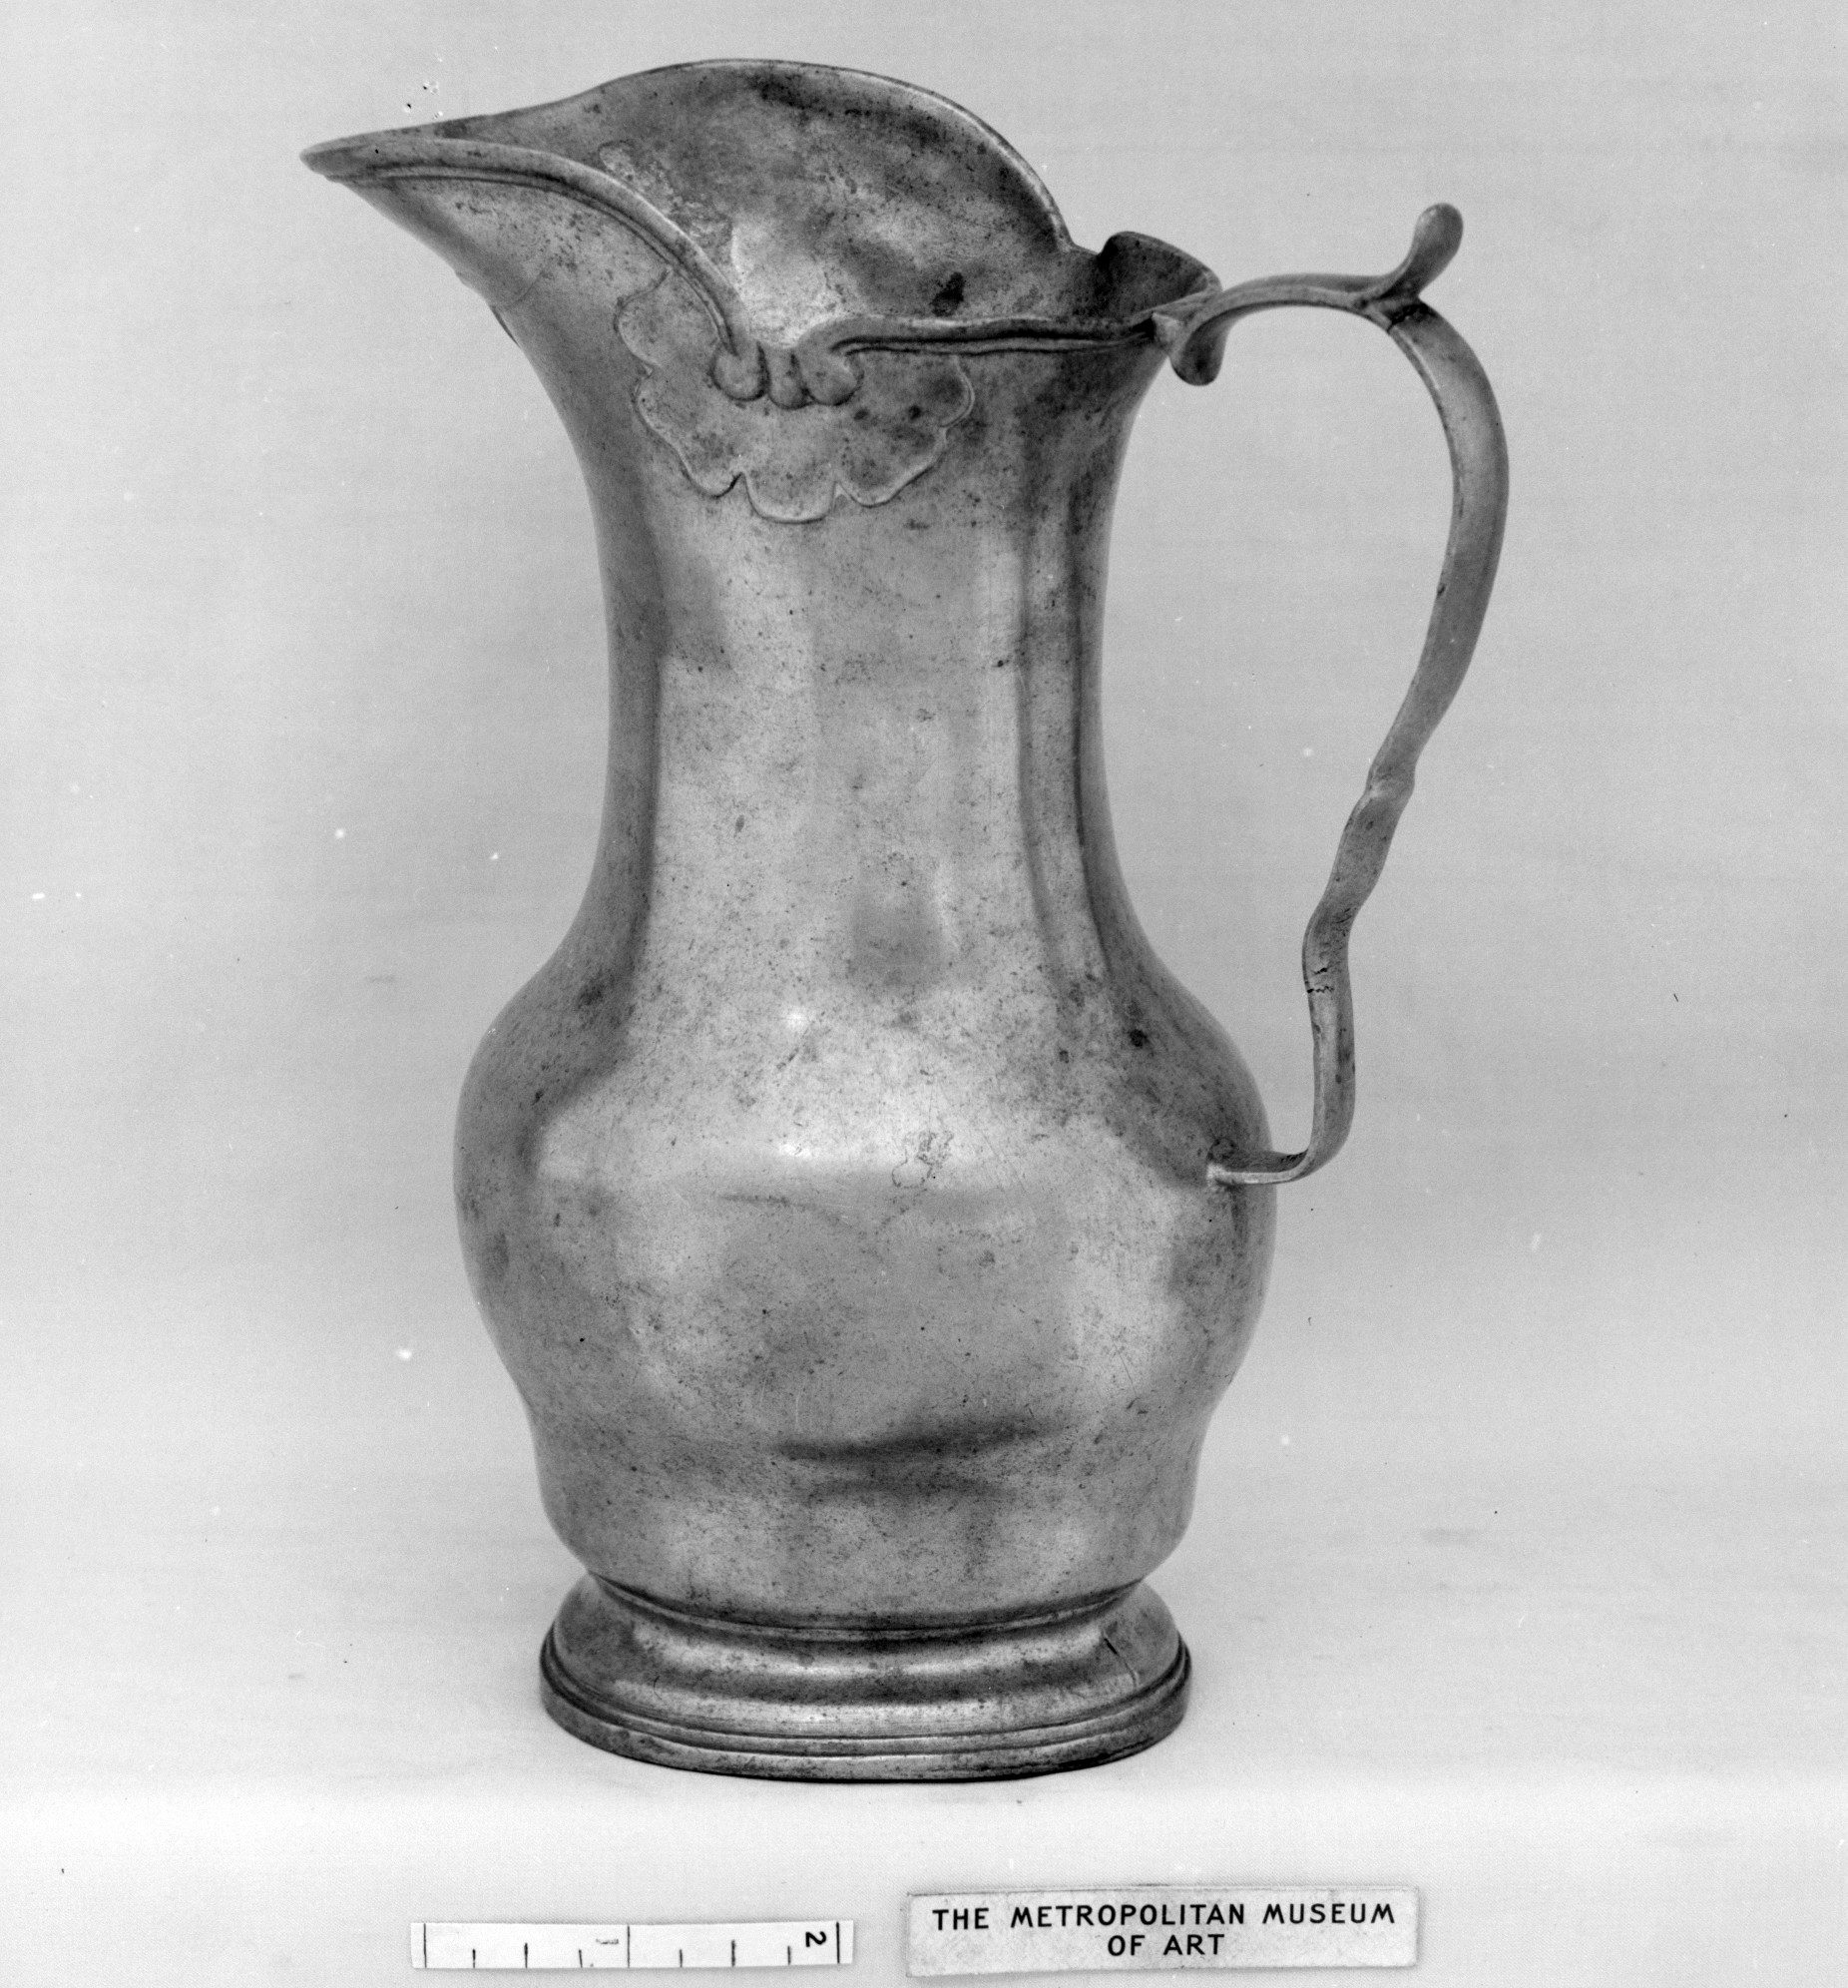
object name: ewer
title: Ewer (part of a set)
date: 1701-1800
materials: pewter